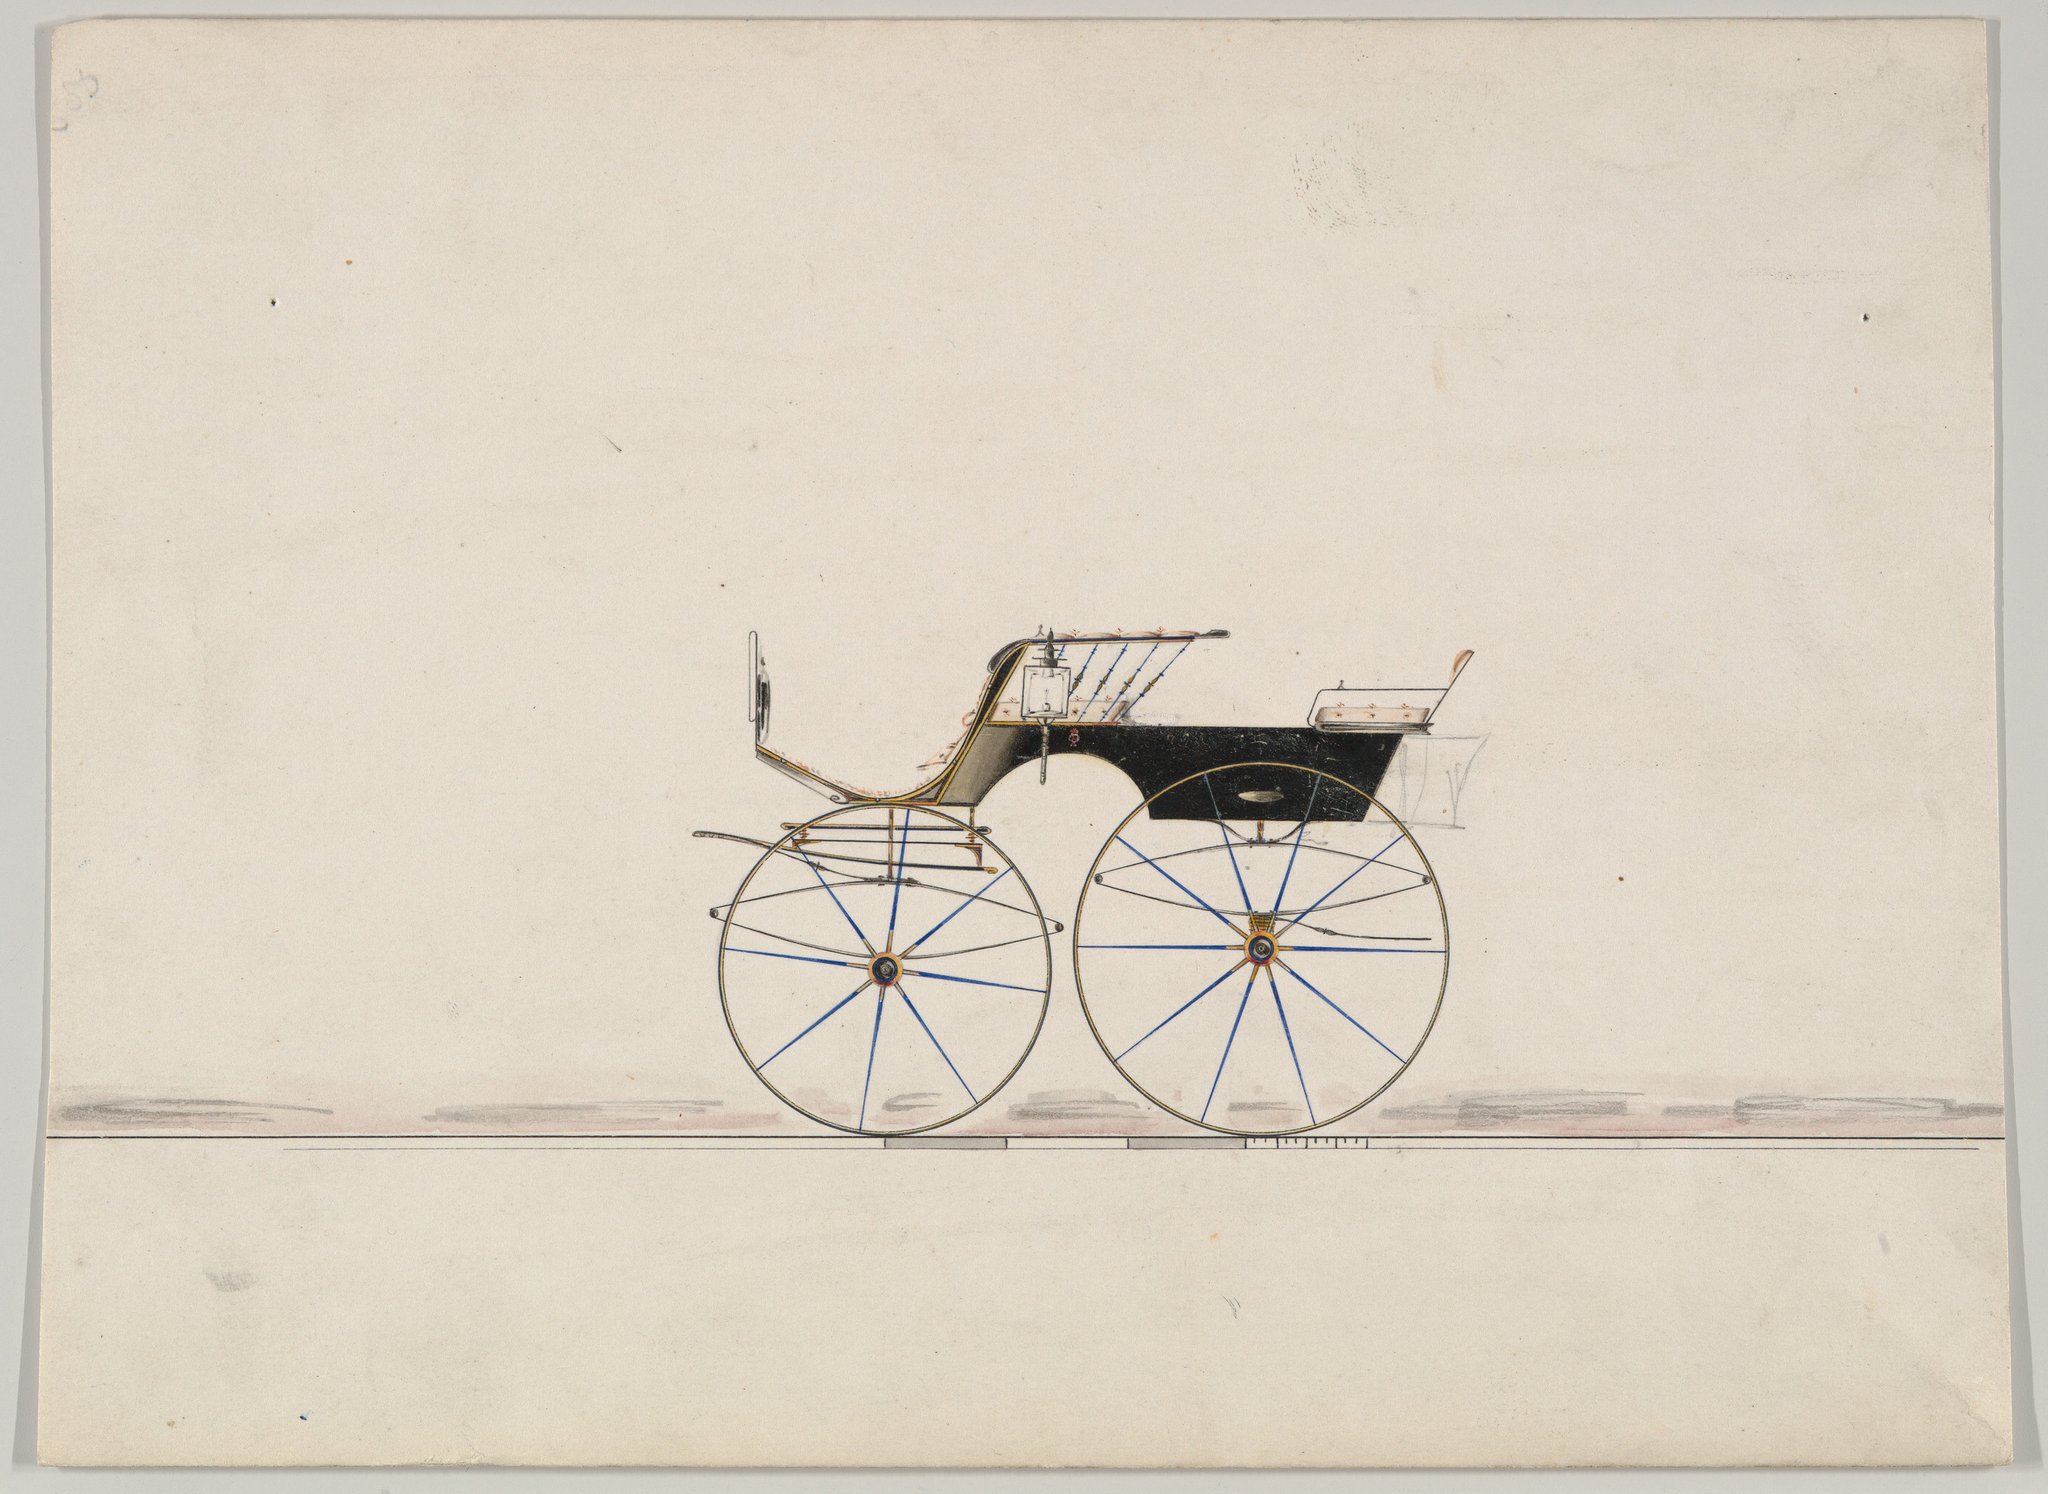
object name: drawing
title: Spindle seat T-Cart Phaeton (unnumbered)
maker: brewster & co.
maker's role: manufacturer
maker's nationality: american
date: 1850-1870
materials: gouache, gum arabic, ink, watercolor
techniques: pen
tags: carriages